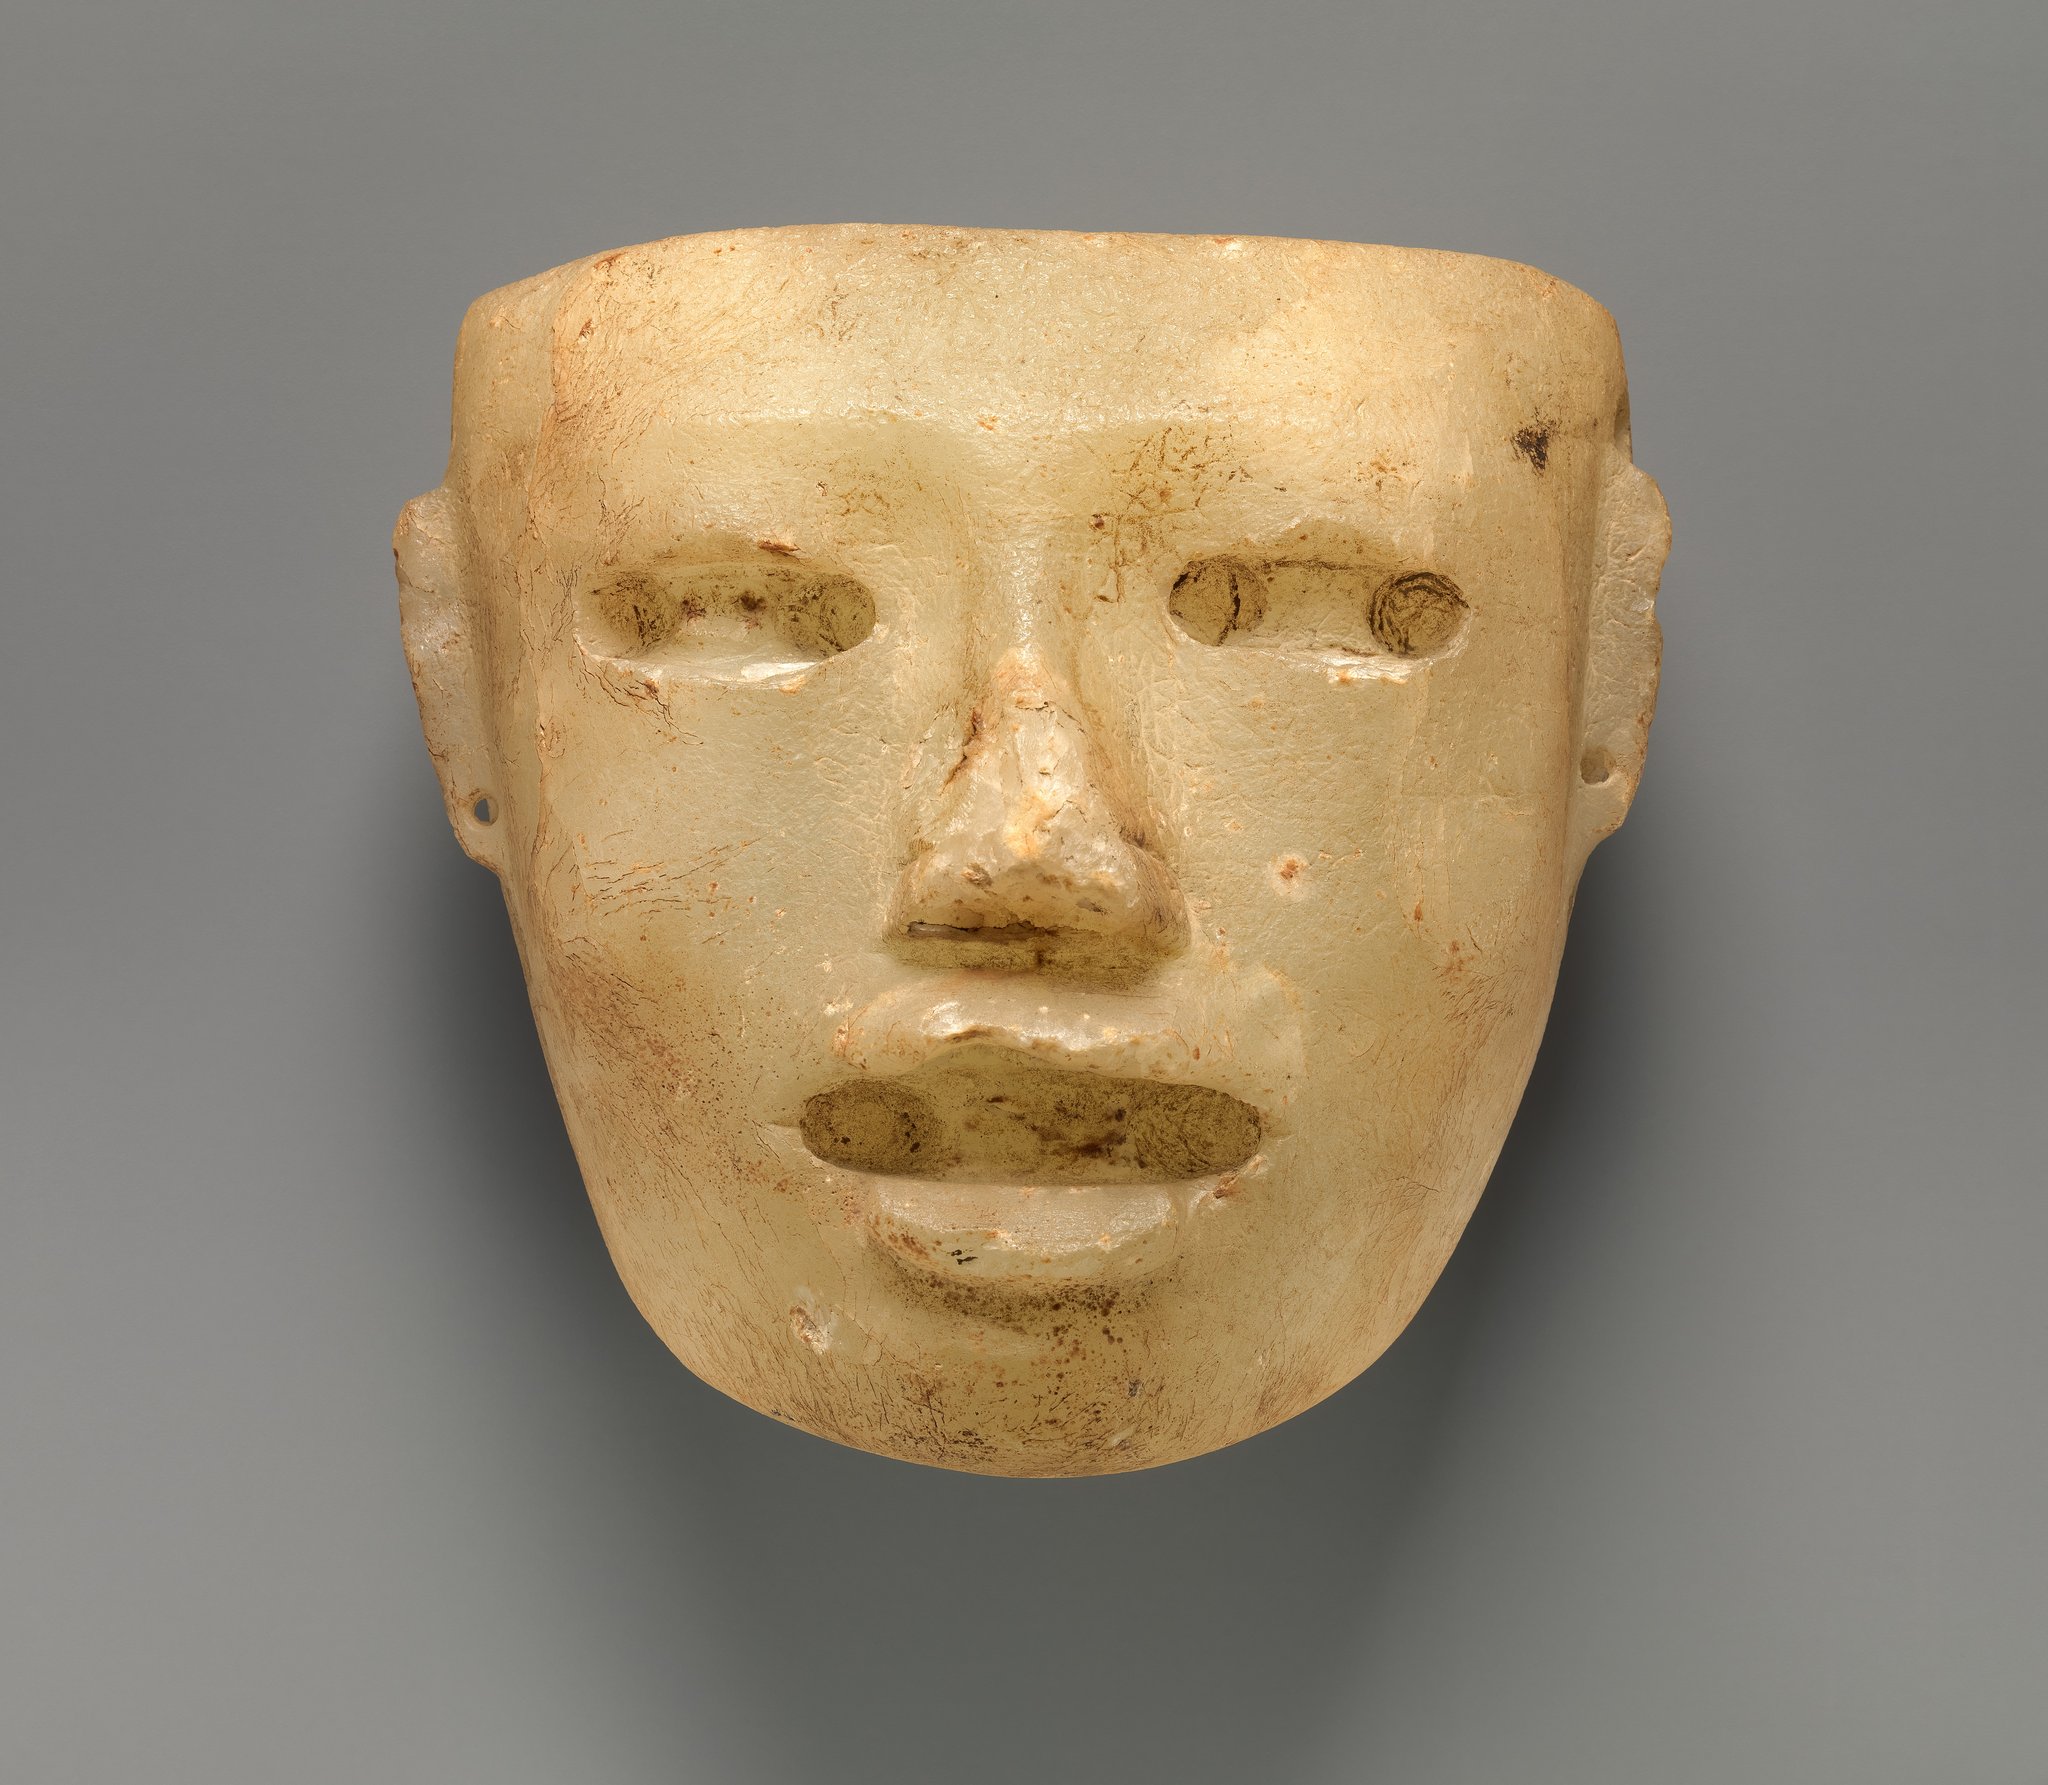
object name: mask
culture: teotihuacan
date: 201-700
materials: stone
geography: mexico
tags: faces